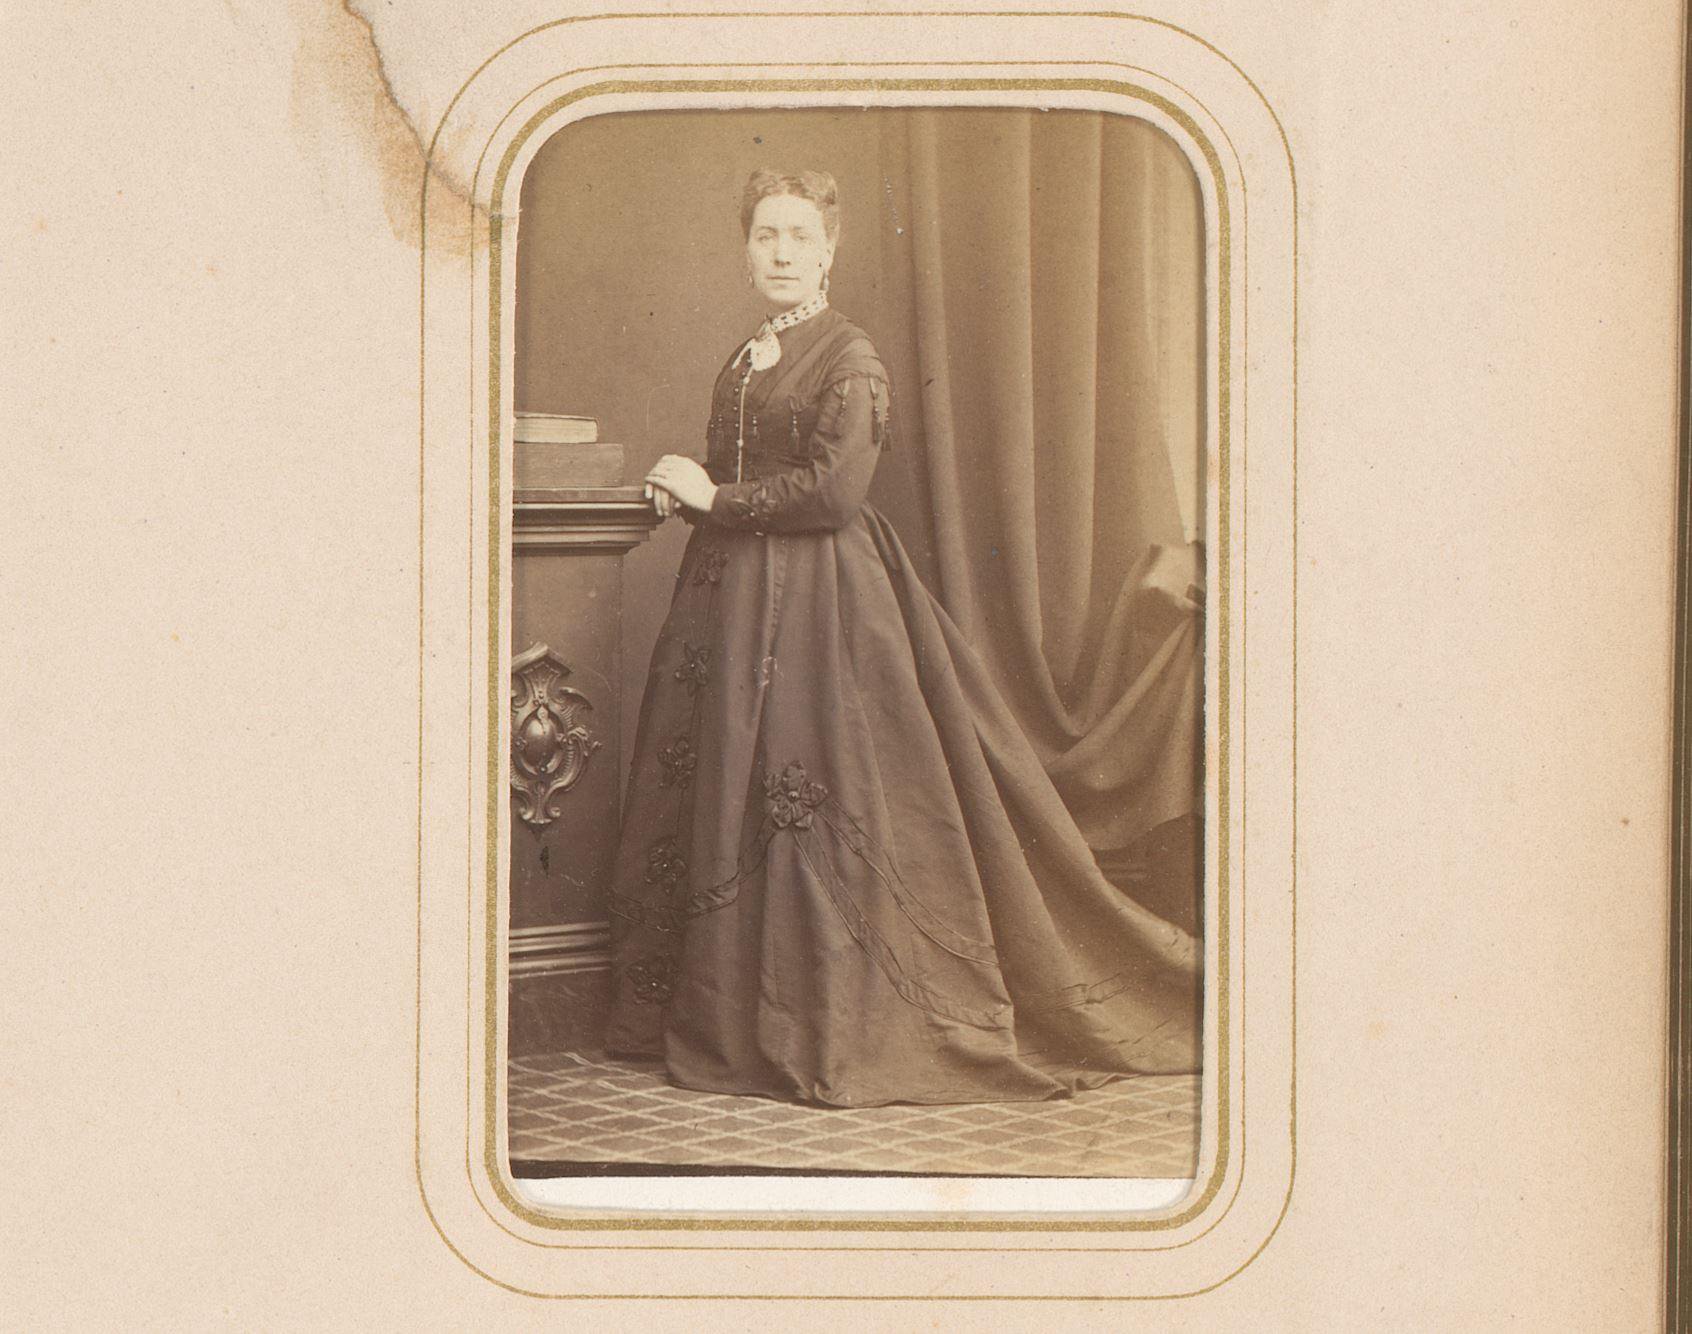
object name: photograph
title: Portret van een vrouw, staand bij een zuil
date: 1860-1900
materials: cardboard, photographic support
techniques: albumen print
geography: dublin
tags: historical persons - bb - woman, pedestal of a piece of sculpture (perhaps in the form of a herm), standing figure - aa - female human figure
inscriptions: inscription: ‘(...)/ ROBERTSON & Co./ 3, GRAFTON STREET/ Dublin’